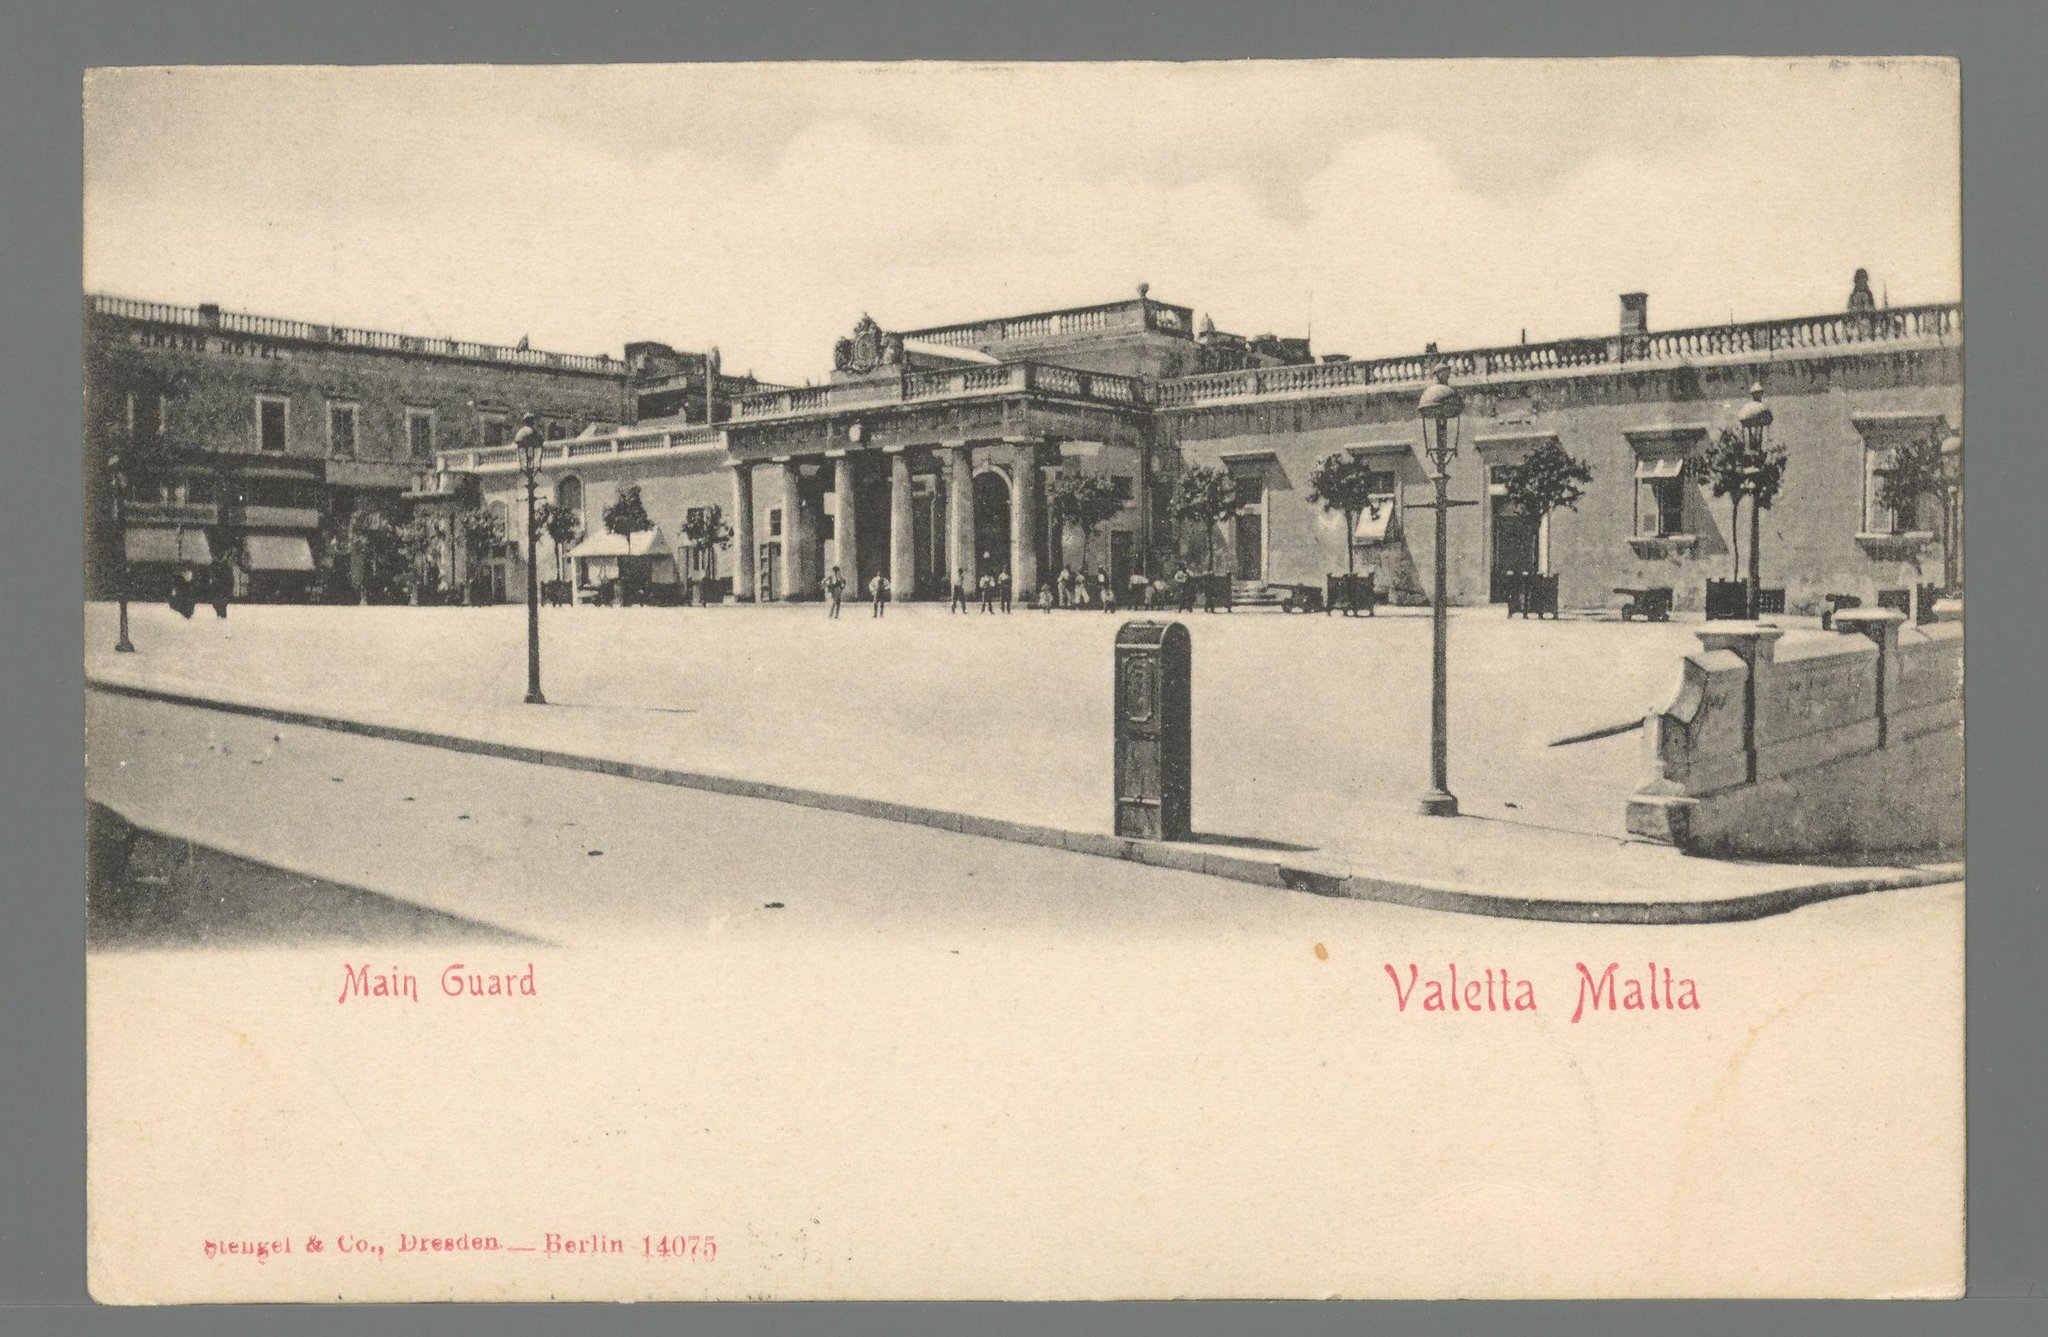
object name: photomechanical print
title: Main Guard. Valetta Malta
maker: Anonymous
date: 1890-1906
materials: cardboard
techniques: photograph, writing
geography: valletta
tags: palace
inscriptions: poststempel, verso, gestempeld